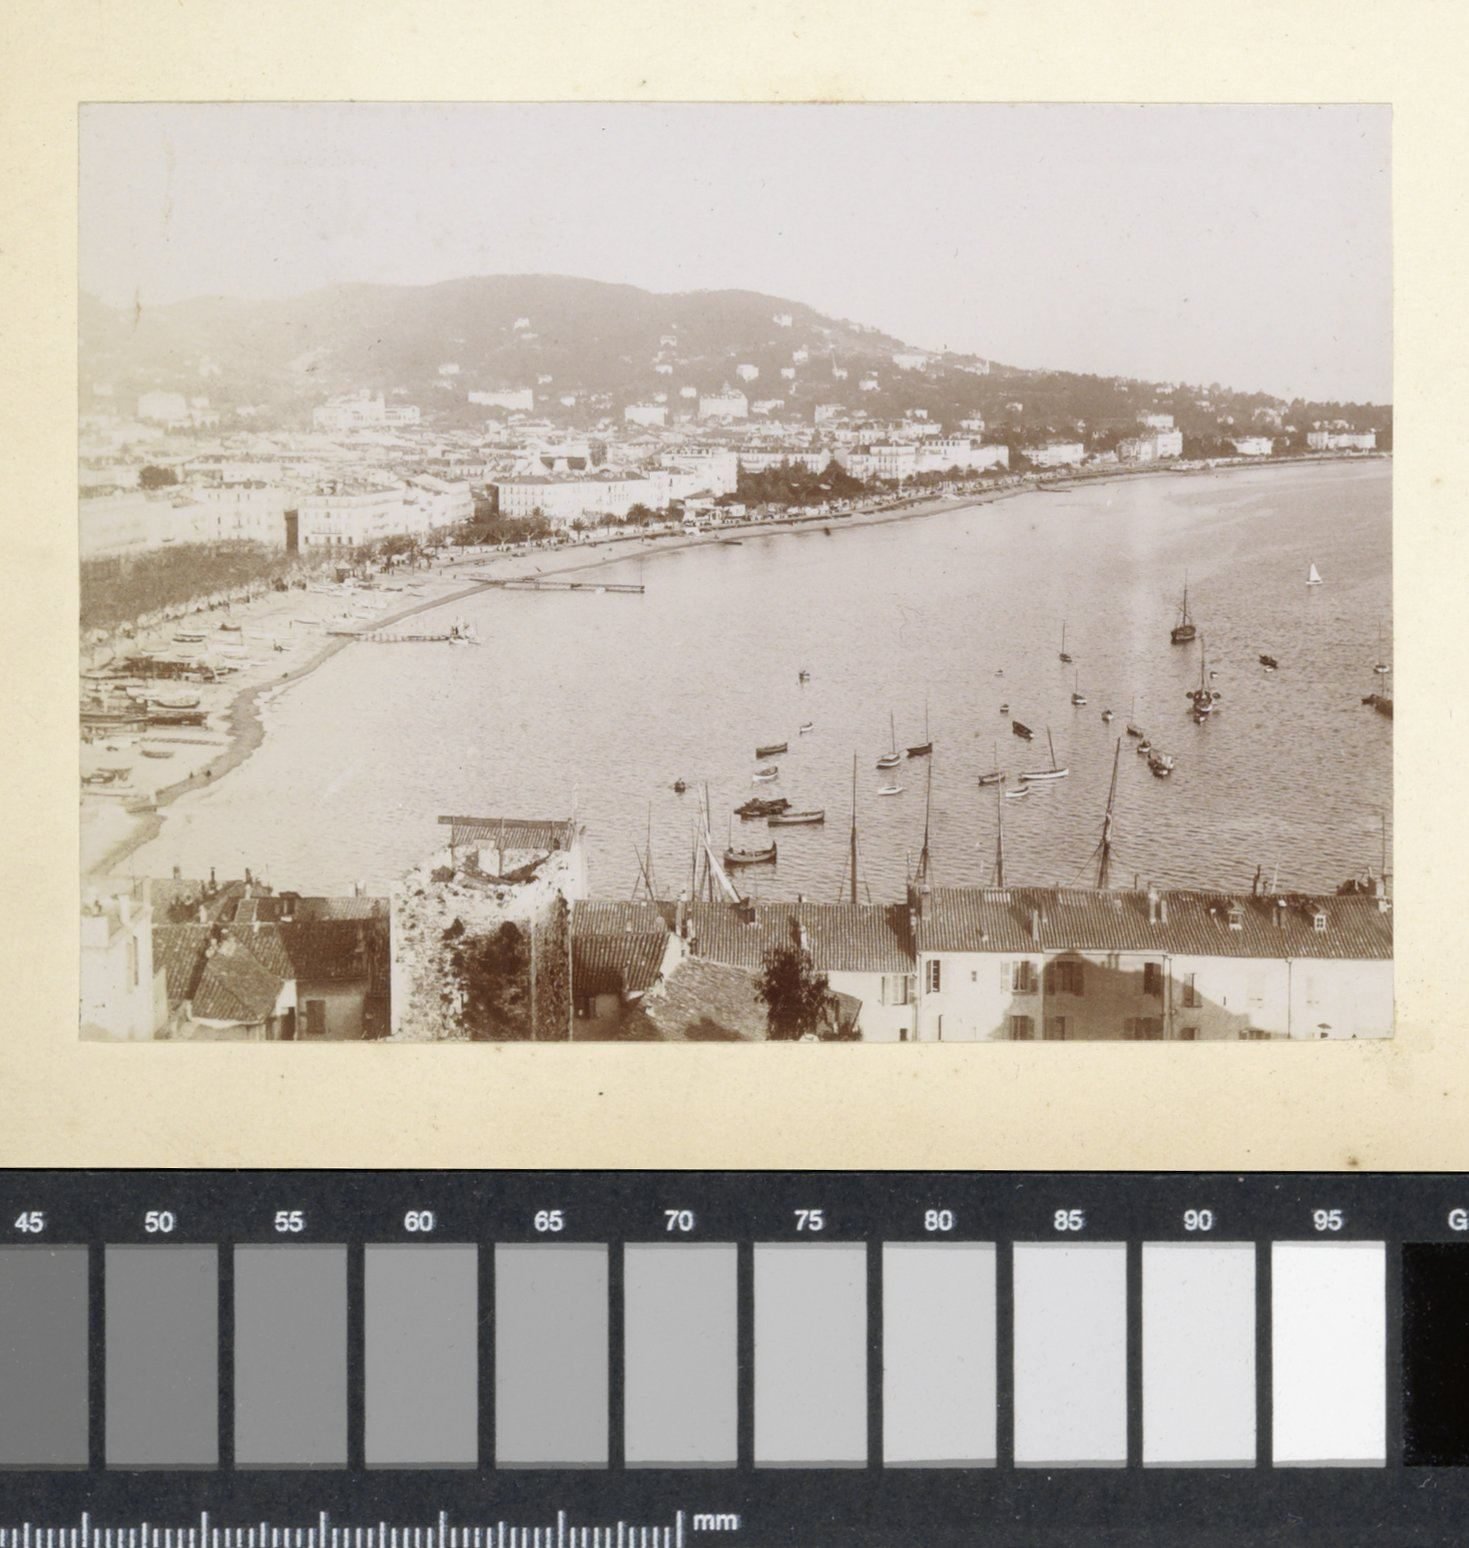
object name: photograph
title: Gezicht op Nice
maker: Anonymous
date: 1895-1900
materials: paper, photographic support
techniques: daylight paper print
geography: nice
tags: coast, prospect of city, town panorama, silhouette of city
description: Gezicht op Cannes vanaf Le Suquet. Onderdeel van Fotoalbum van een Franse amateurfotograaf met opnames van een familie, distilleerderij Delizy & Doistau Fils, het leger en bezienswaardigheden in Frankrijk.